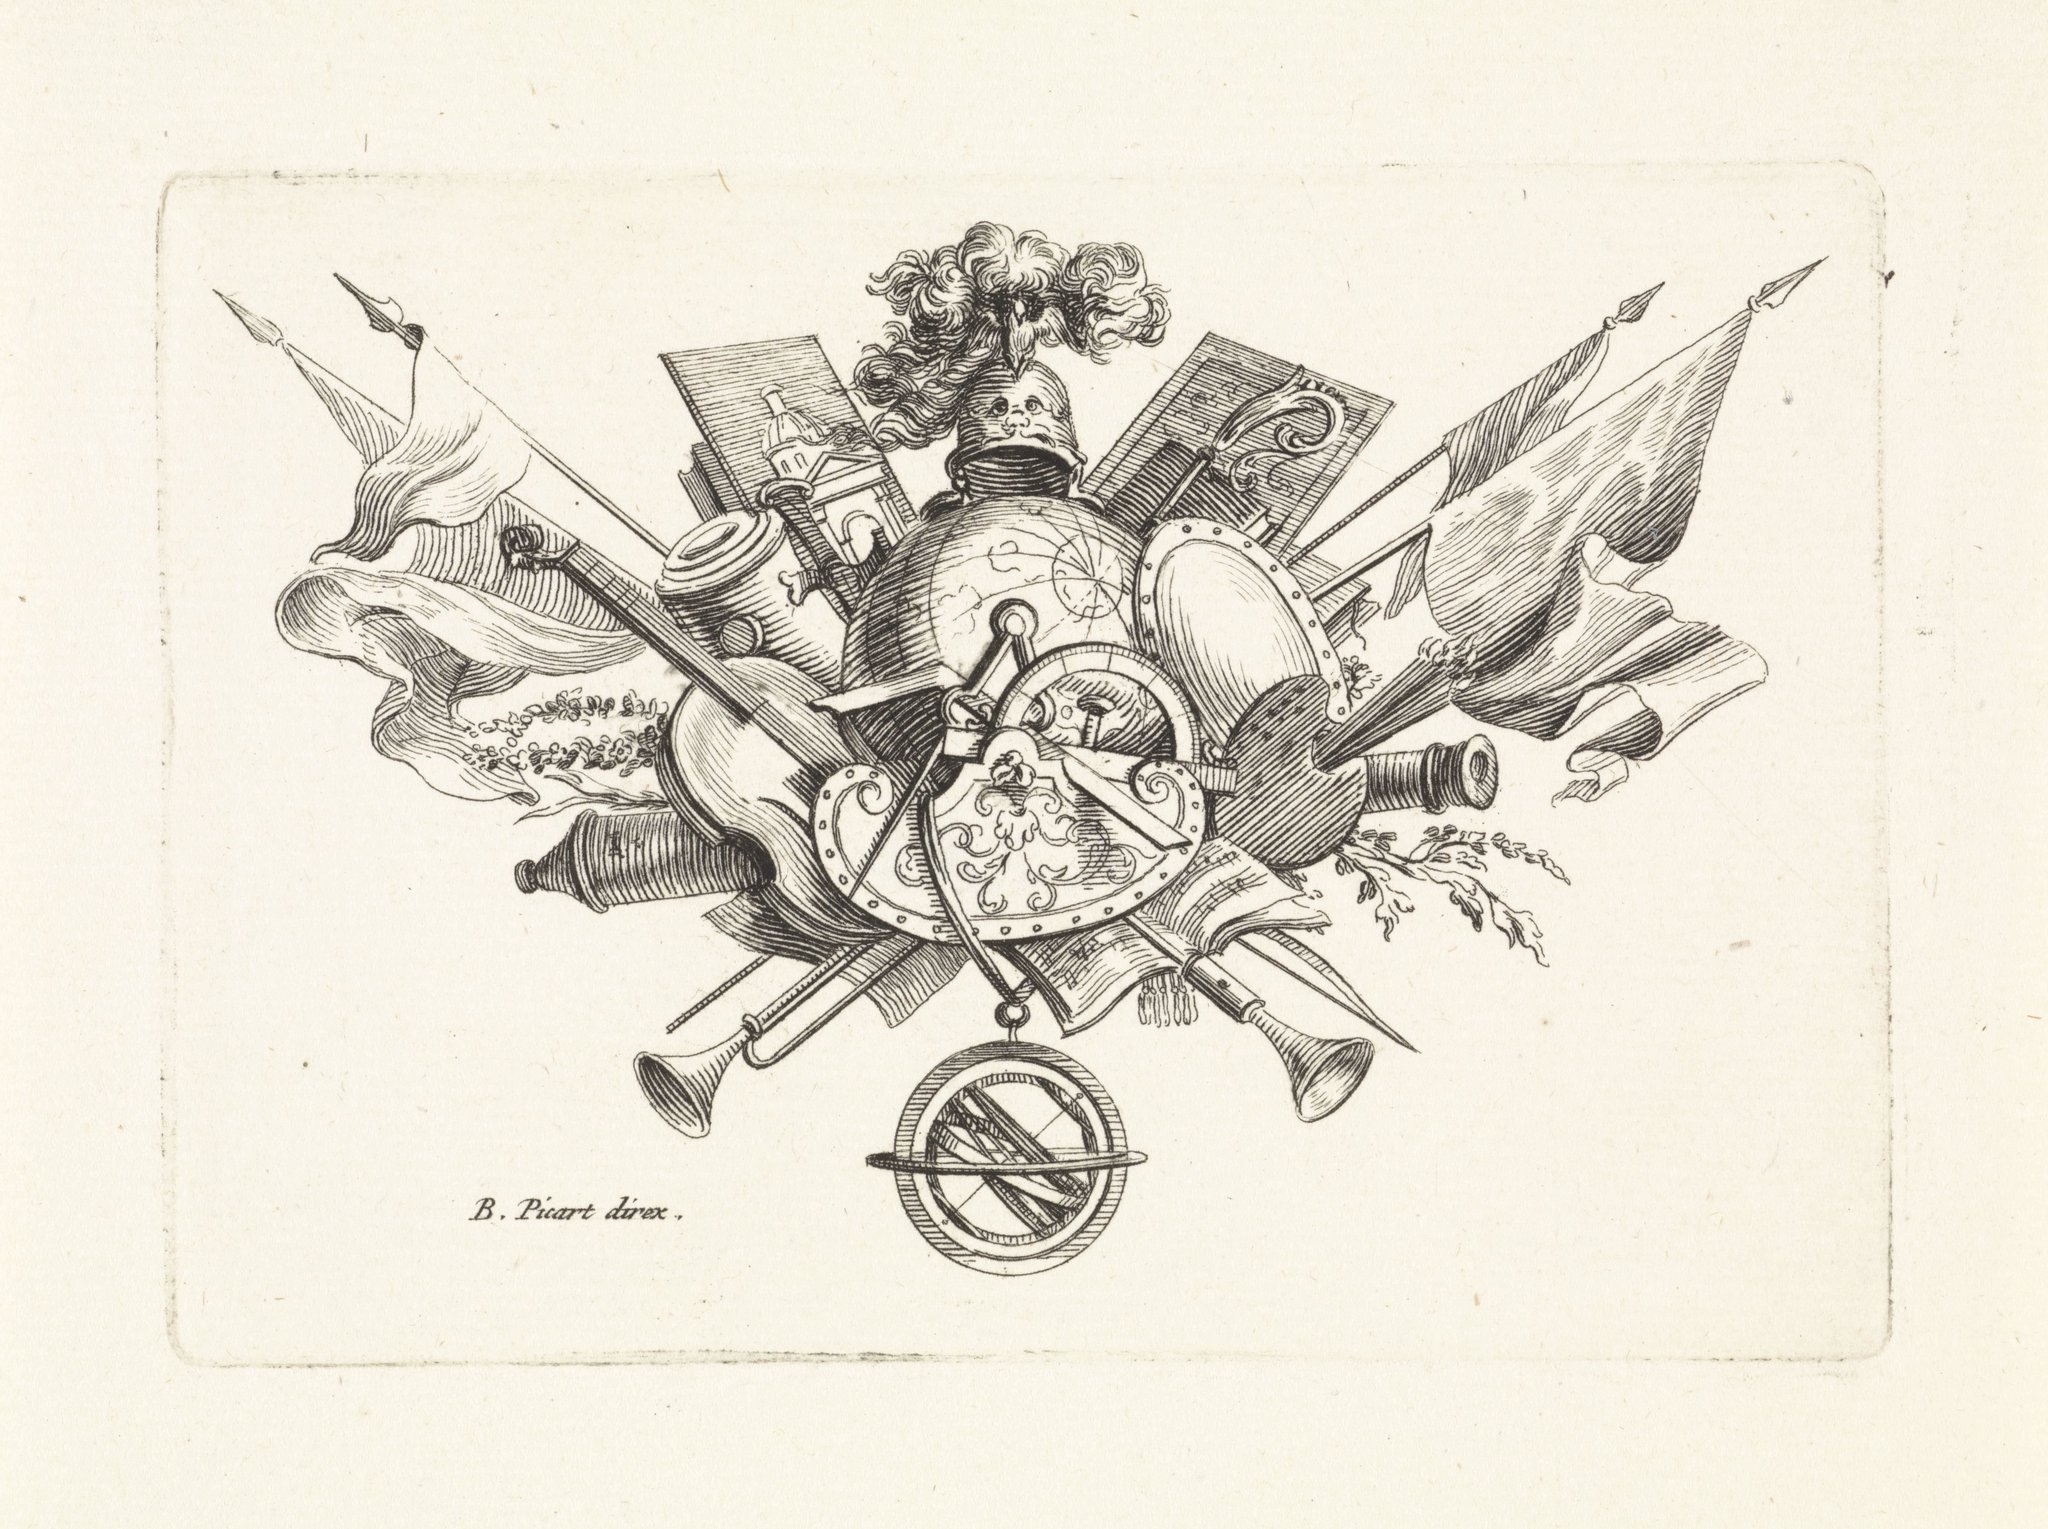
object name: print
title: Attributen van wetenschap en kunsten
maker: bernard picart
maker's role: draughtsman, print maker, publisher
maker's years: 1673-1733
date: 1683-1733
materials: paper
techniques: engraving, etching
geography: amsterdam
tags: attributes of minerva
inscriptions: collector's mark: Lugt 2233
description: Attributen van wetenschap, zoals globe en passer. Daarnaast attributen van de kunsten, als viool, bladmuziek en schilderspalet.